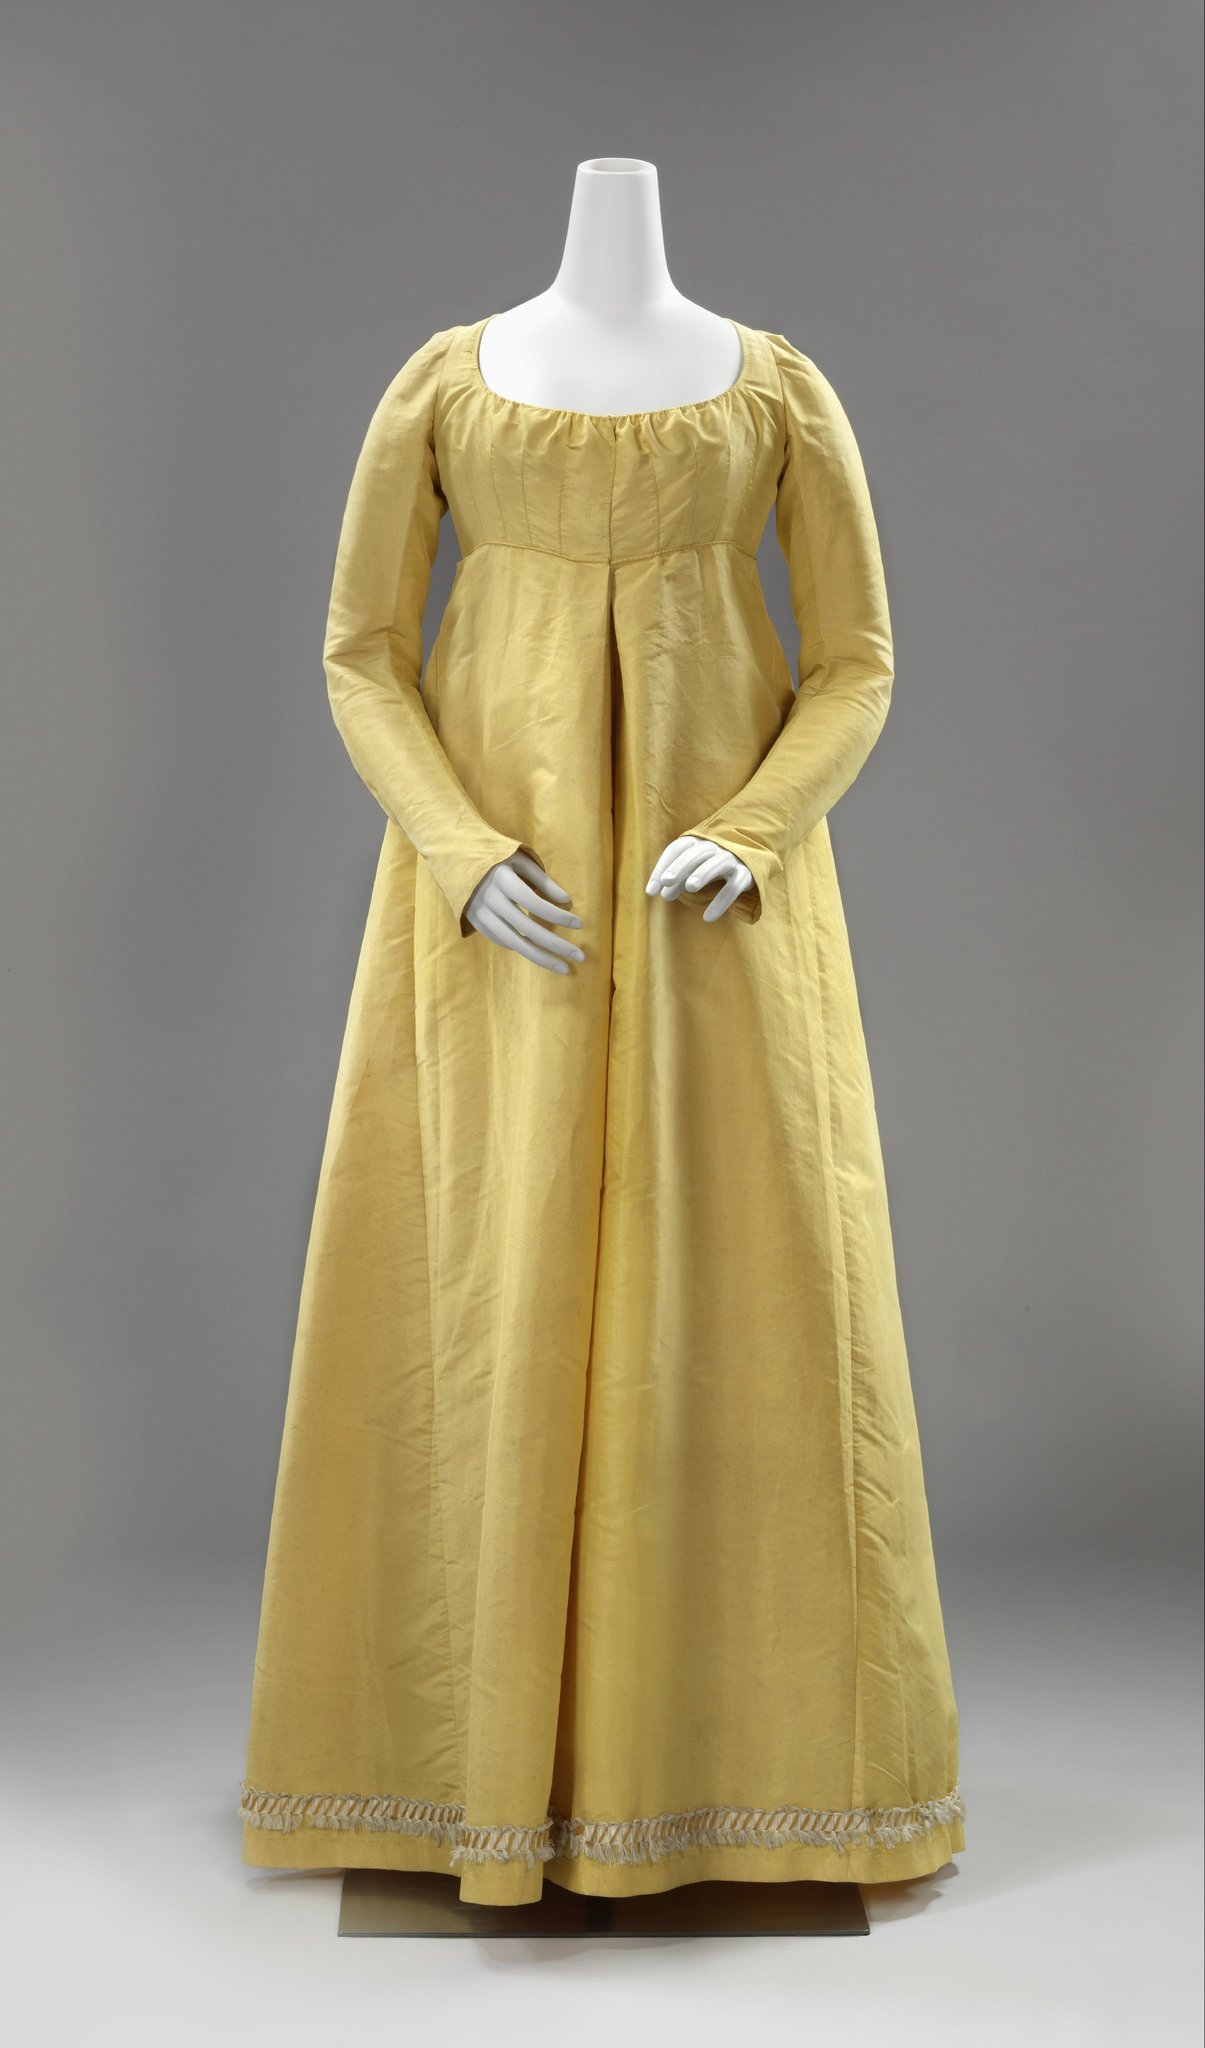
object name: womenswear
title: Gown with a diamond-shaped back panel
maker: Anonymous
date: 1790-1810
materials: linen, metal, silk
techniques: weave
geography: france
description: At the end of the 18th century a new dye came onto the European market, namely an extract from the bark of the American black oak. This made it easier and cheaper to dye fabrics yellow. This colour consequently became fashionable in Paris. It also remained popular in the Netherlands until the early 19th century.